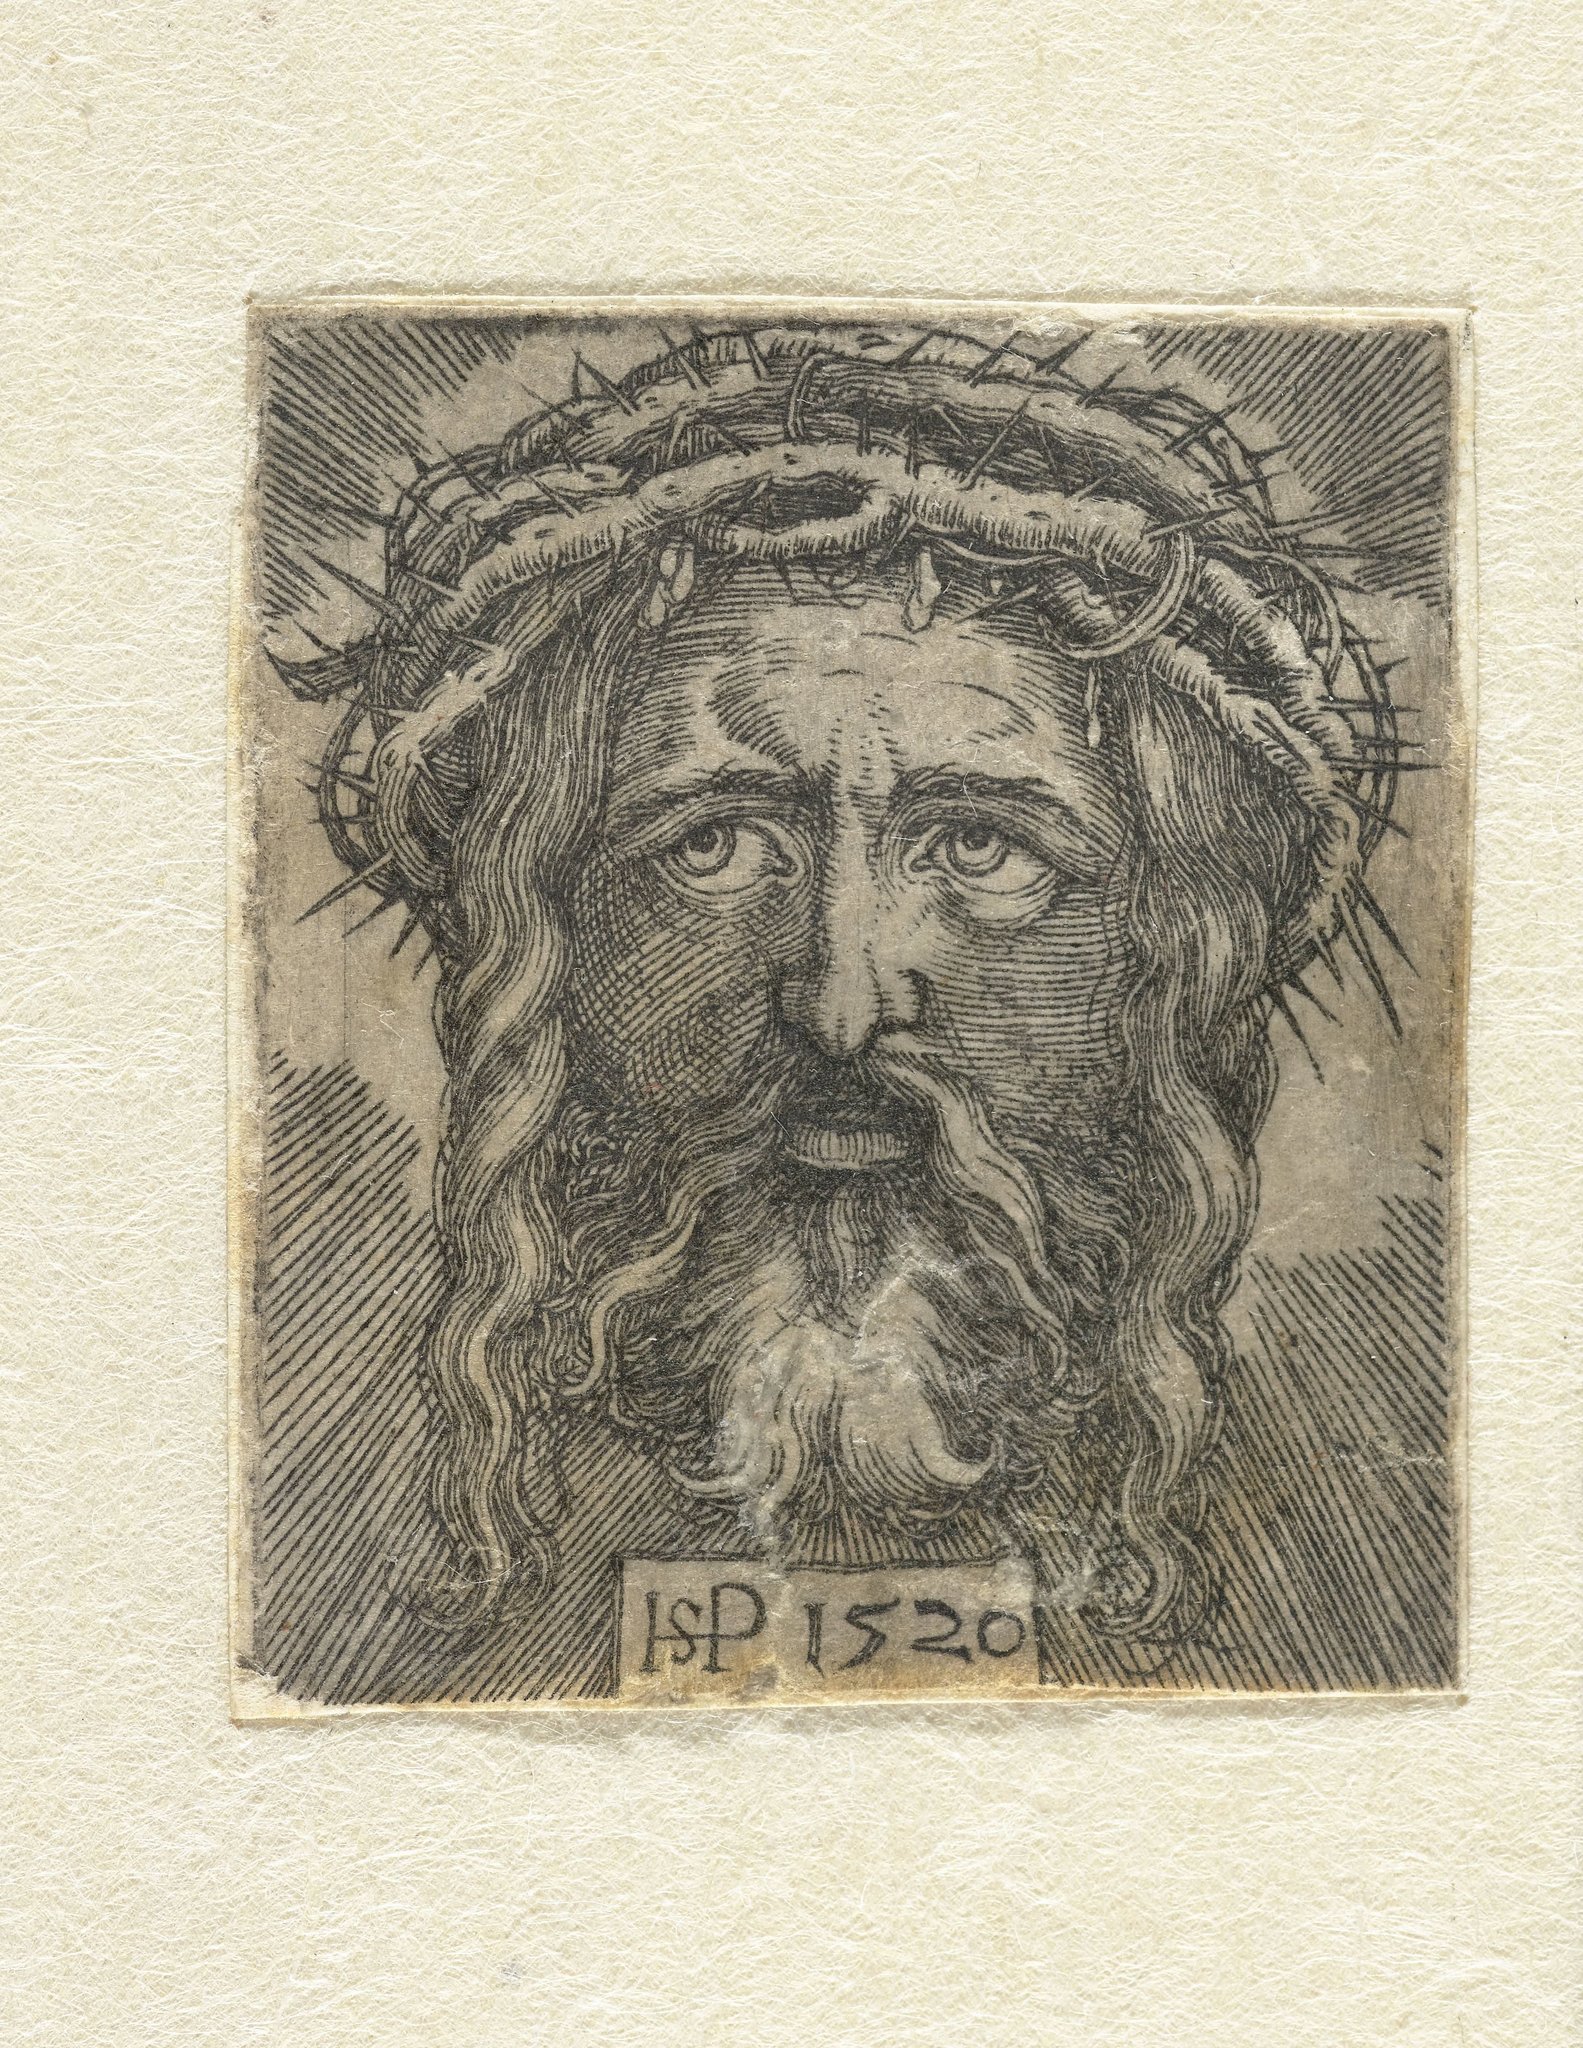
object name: print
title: Hoofd van Christus met doornenkroon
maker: hans sebald beham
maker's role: designer, draughtsman, print maker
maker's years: 1500-1550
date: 1520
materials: paper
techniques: engraving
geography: nuremberg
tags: christ suffering (with crown of thorns, head usually turned sidewards)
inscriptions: collector's mark: Lugt 240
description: Bij Bartsch beschreven als kopie maar weerlegd door Pauli, zie documentatie